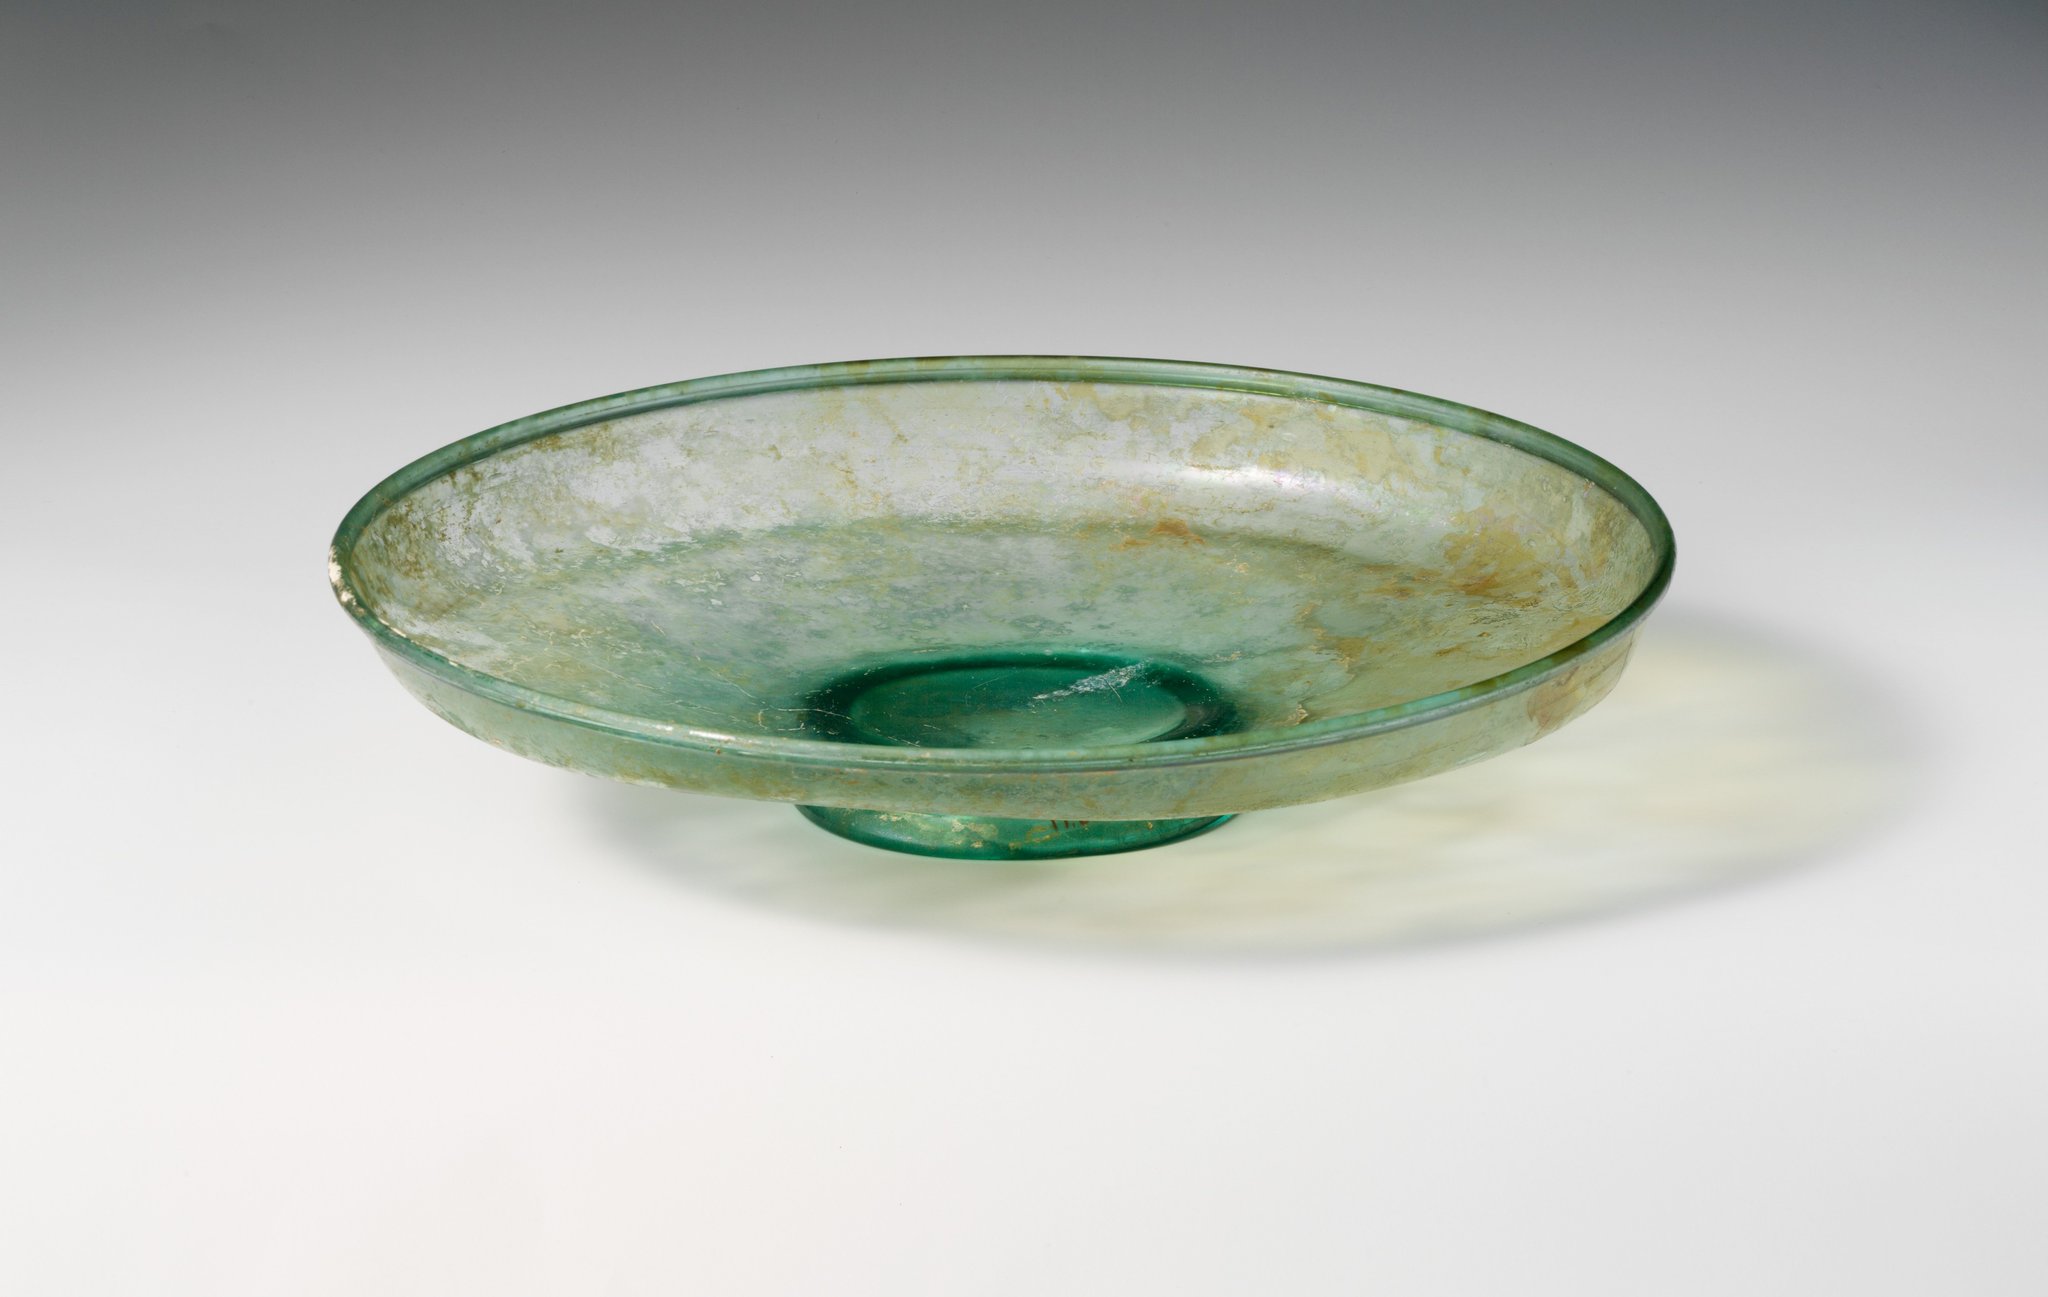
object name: dish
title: Glass dish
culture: roman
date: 301-400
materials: glass